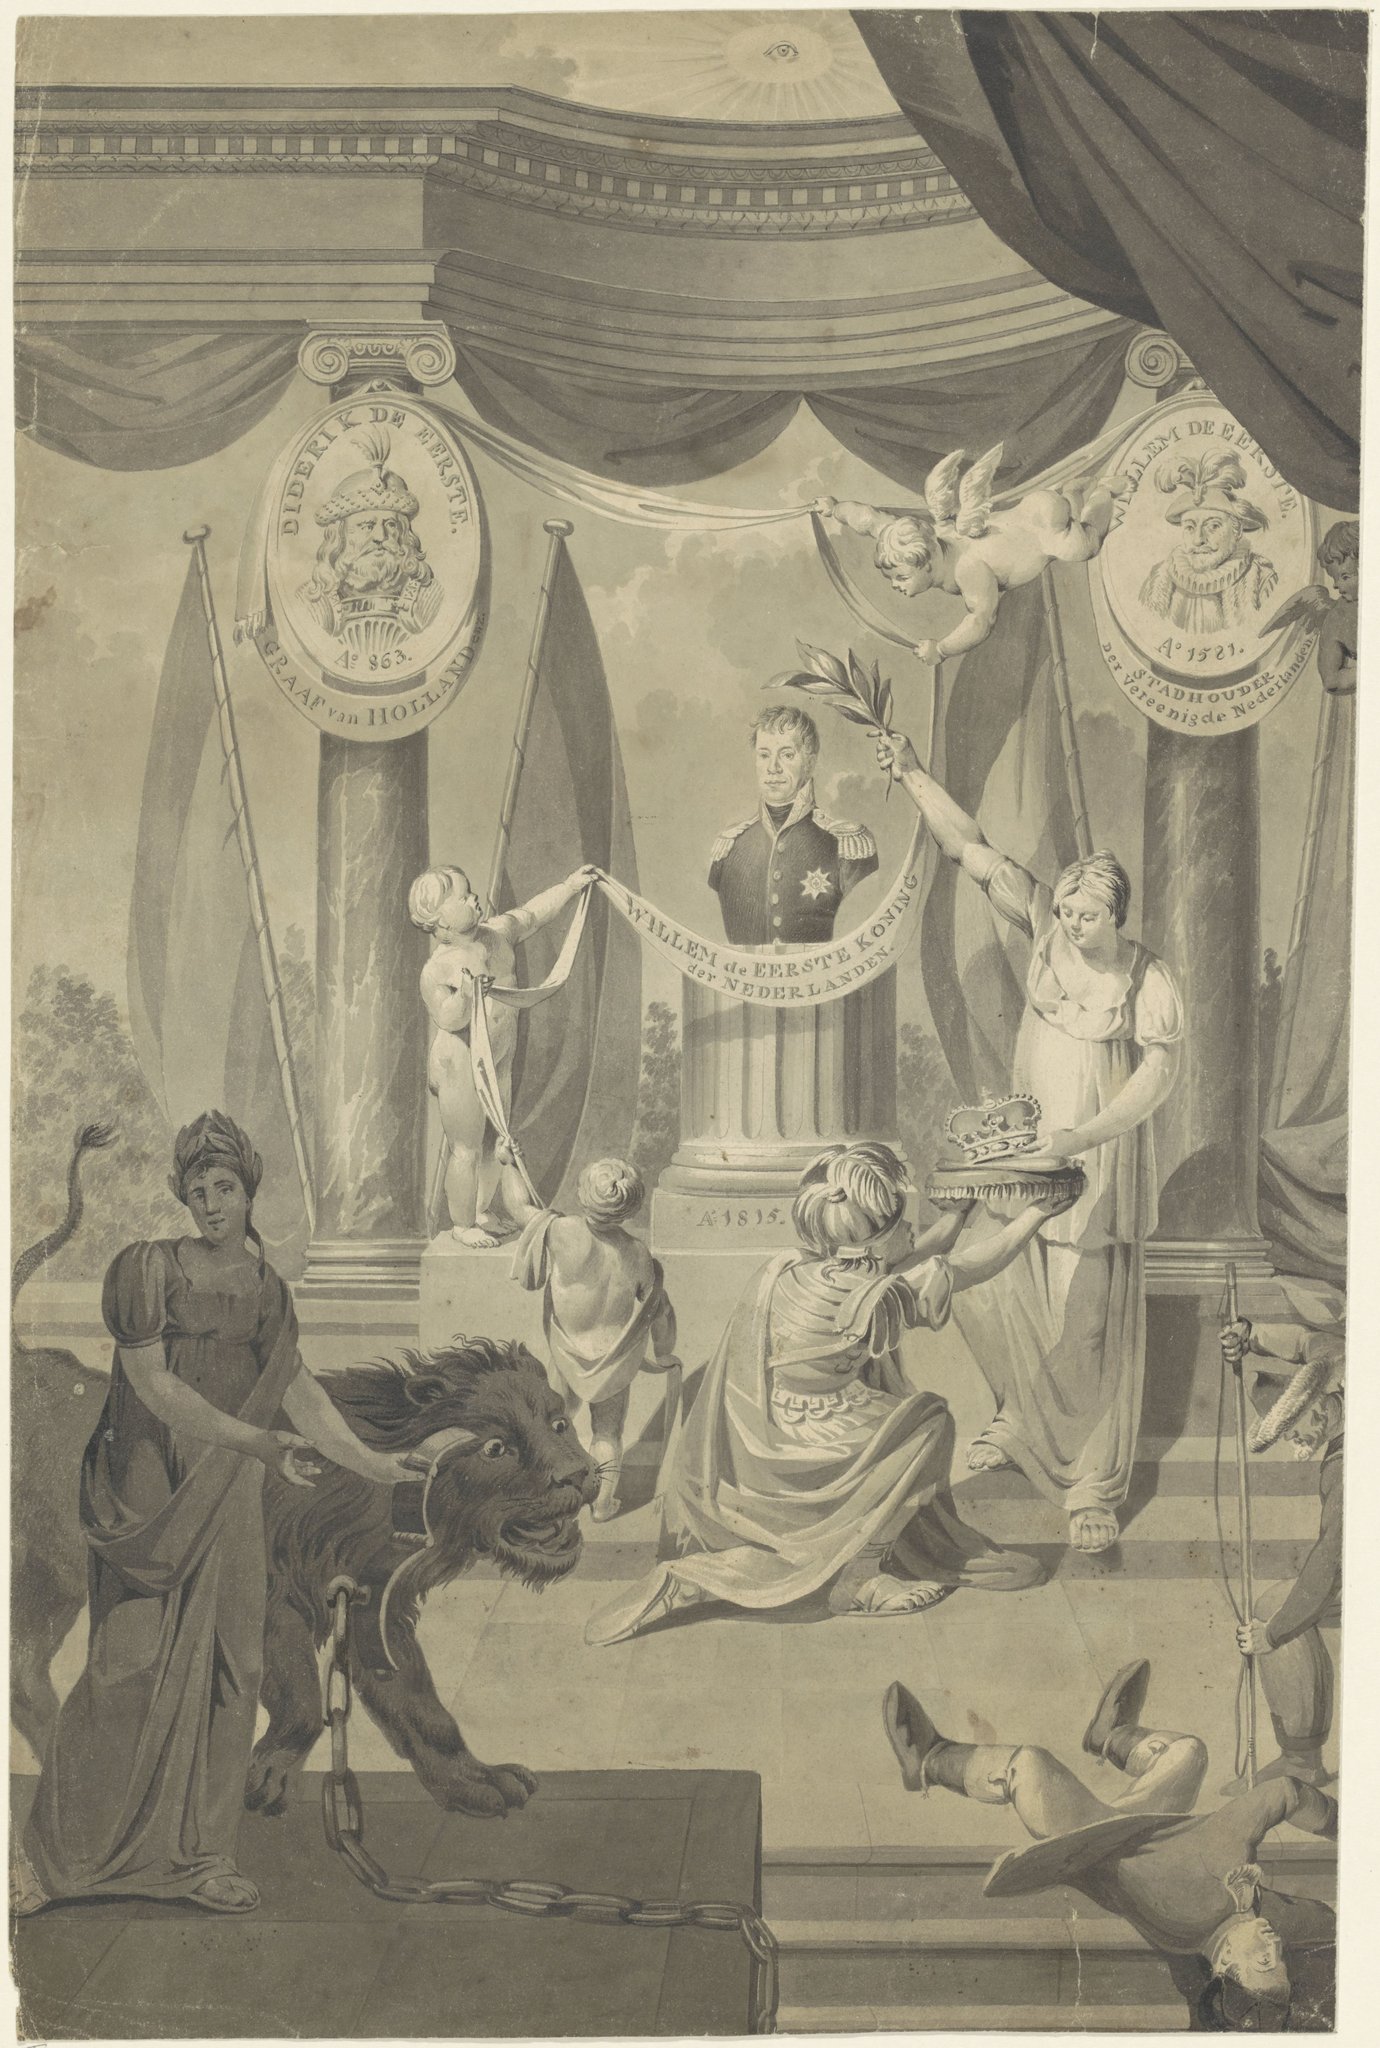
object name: drawing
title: Allegorie op de inhuldiging van Willem I Frederik, koning der Nederlanden, op het Koningsplein te Brussel op 21 september 1815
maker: Anonymous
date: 1815-1817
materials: paper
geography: netherlands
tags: berlin, william i of the netherlands, delft, william i (prince of orange), piece of sculpture, reproduction of a piece of sculpture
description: Allegorie op de inhuldiging van Willem I Frederik op het Koningsplein te Brussel op 21 september 1815. Buste van Willem I Frederik op een zuil. Linksboven een portret van Dirk I in een ovaal met randschrift. Rechtsboven een portret van Willem I in een ovaal met randschrift. Daar omheen een aantal allegorische objecten en figuren die verwijzen naar de inhuldiging van Willem I Frederik.